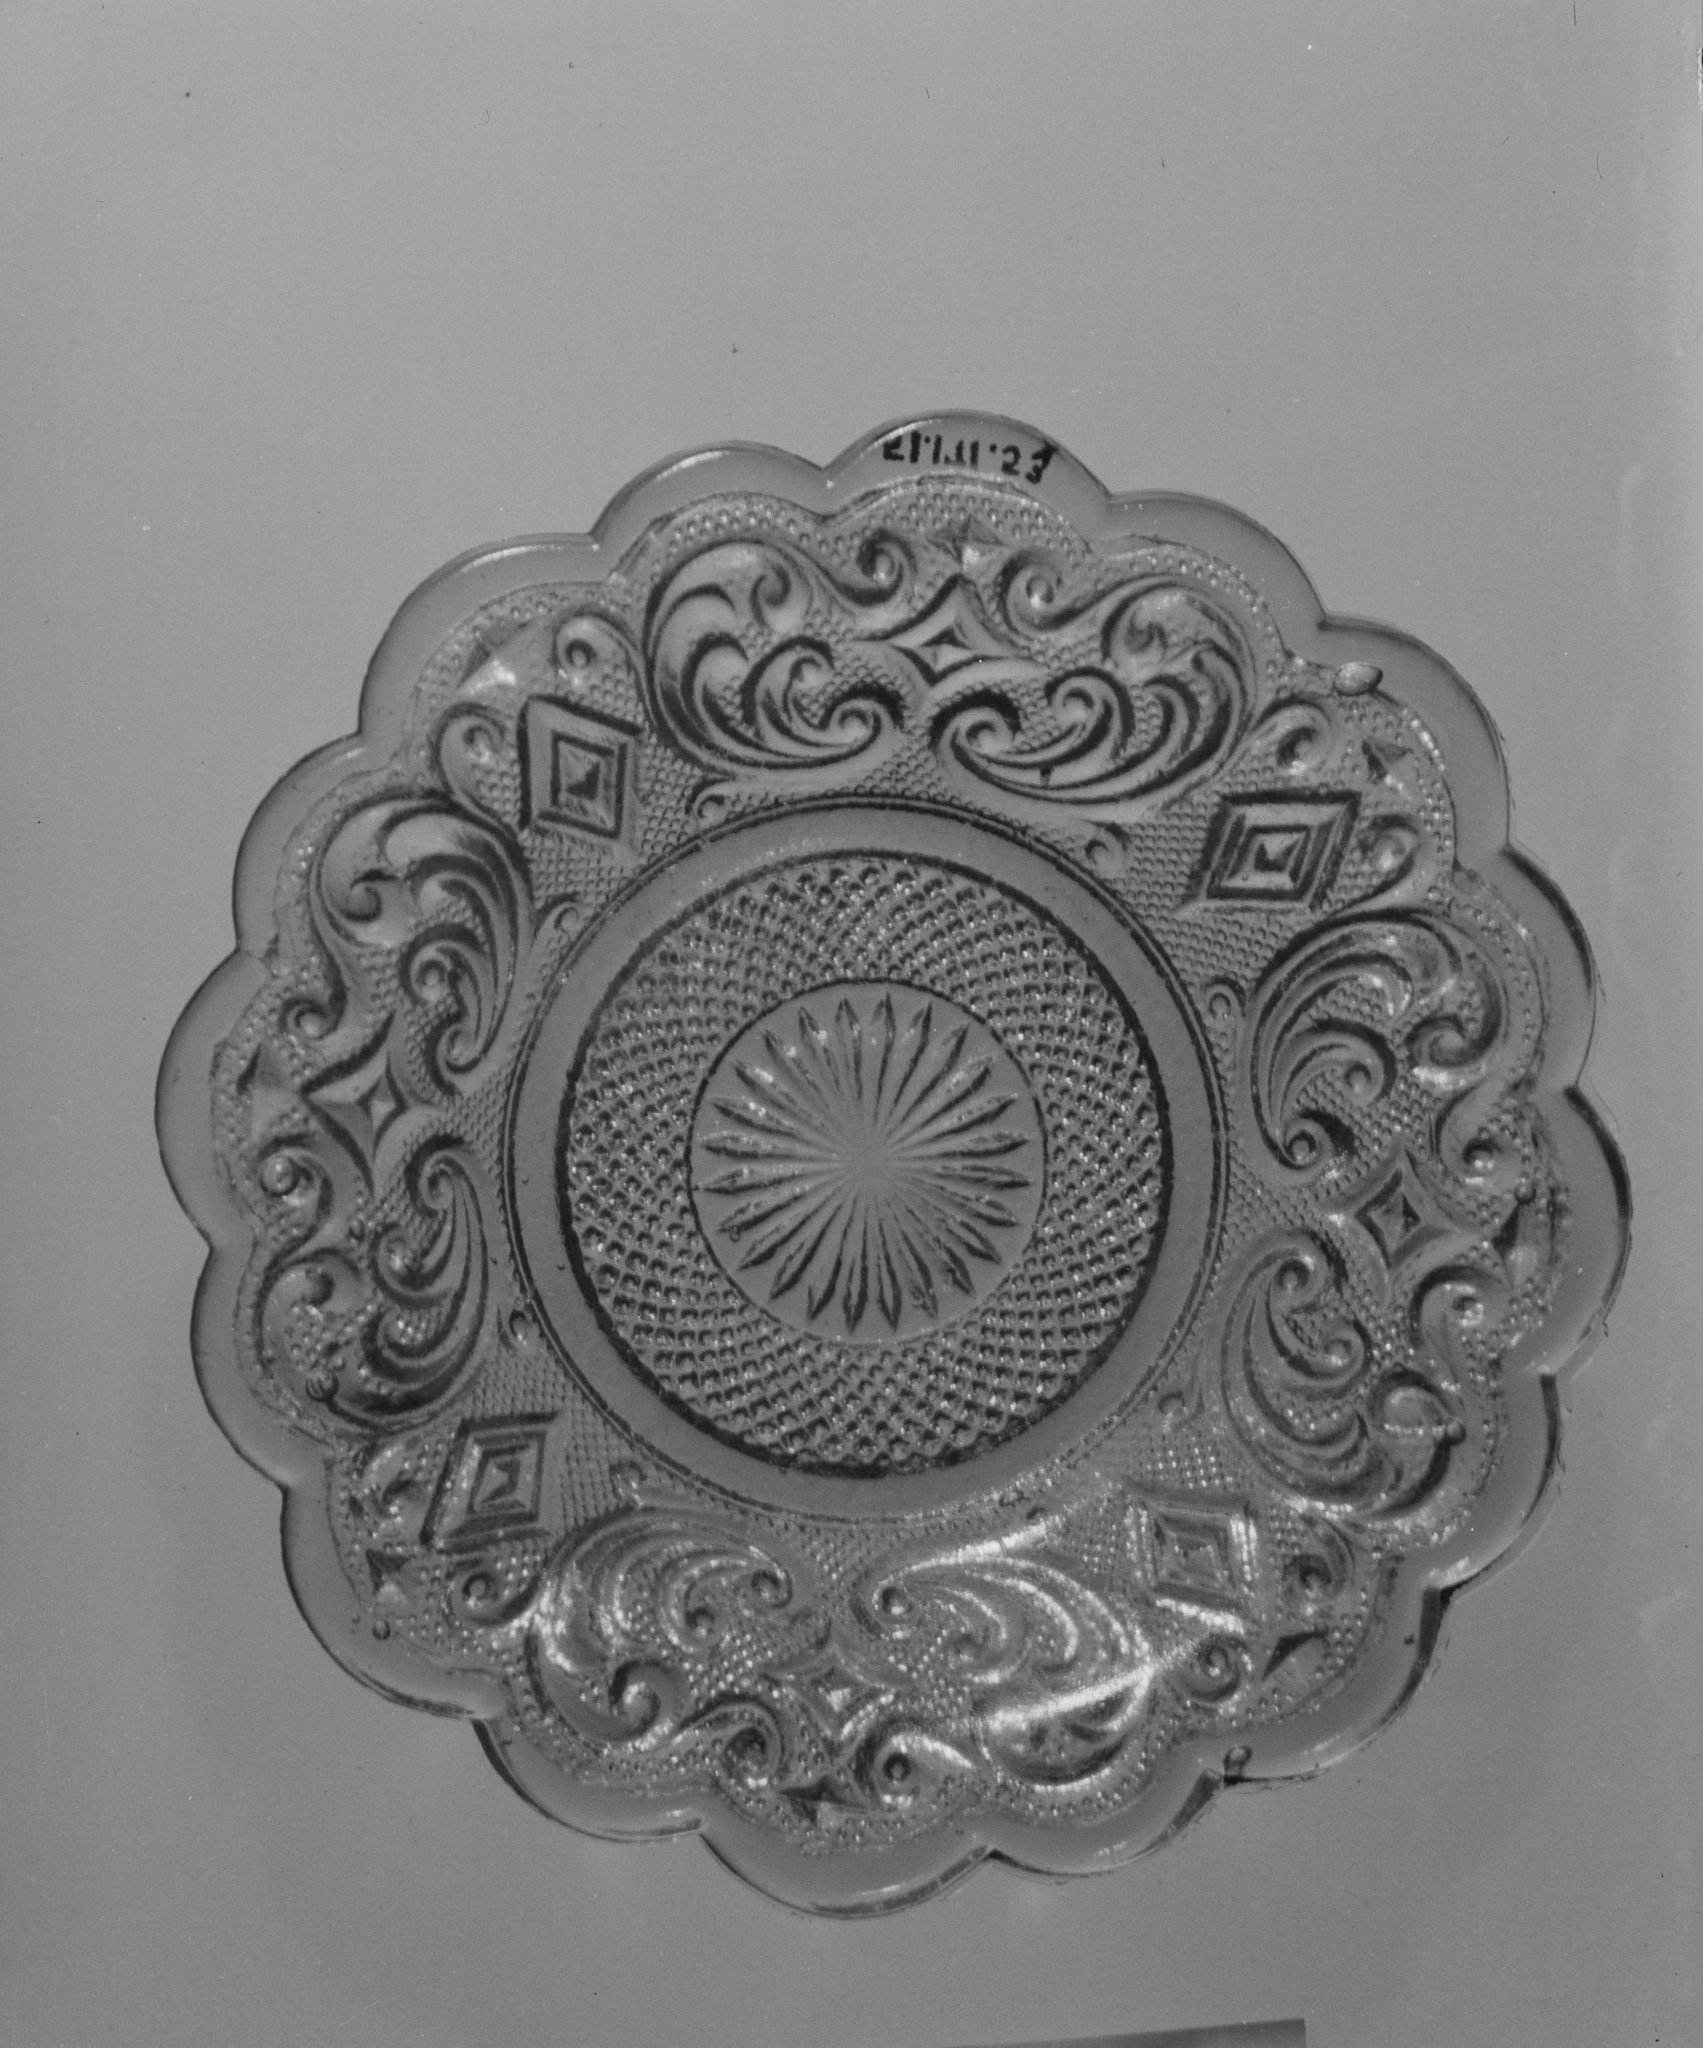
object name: dish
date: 1830-1850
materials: glass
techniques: pressed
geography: france